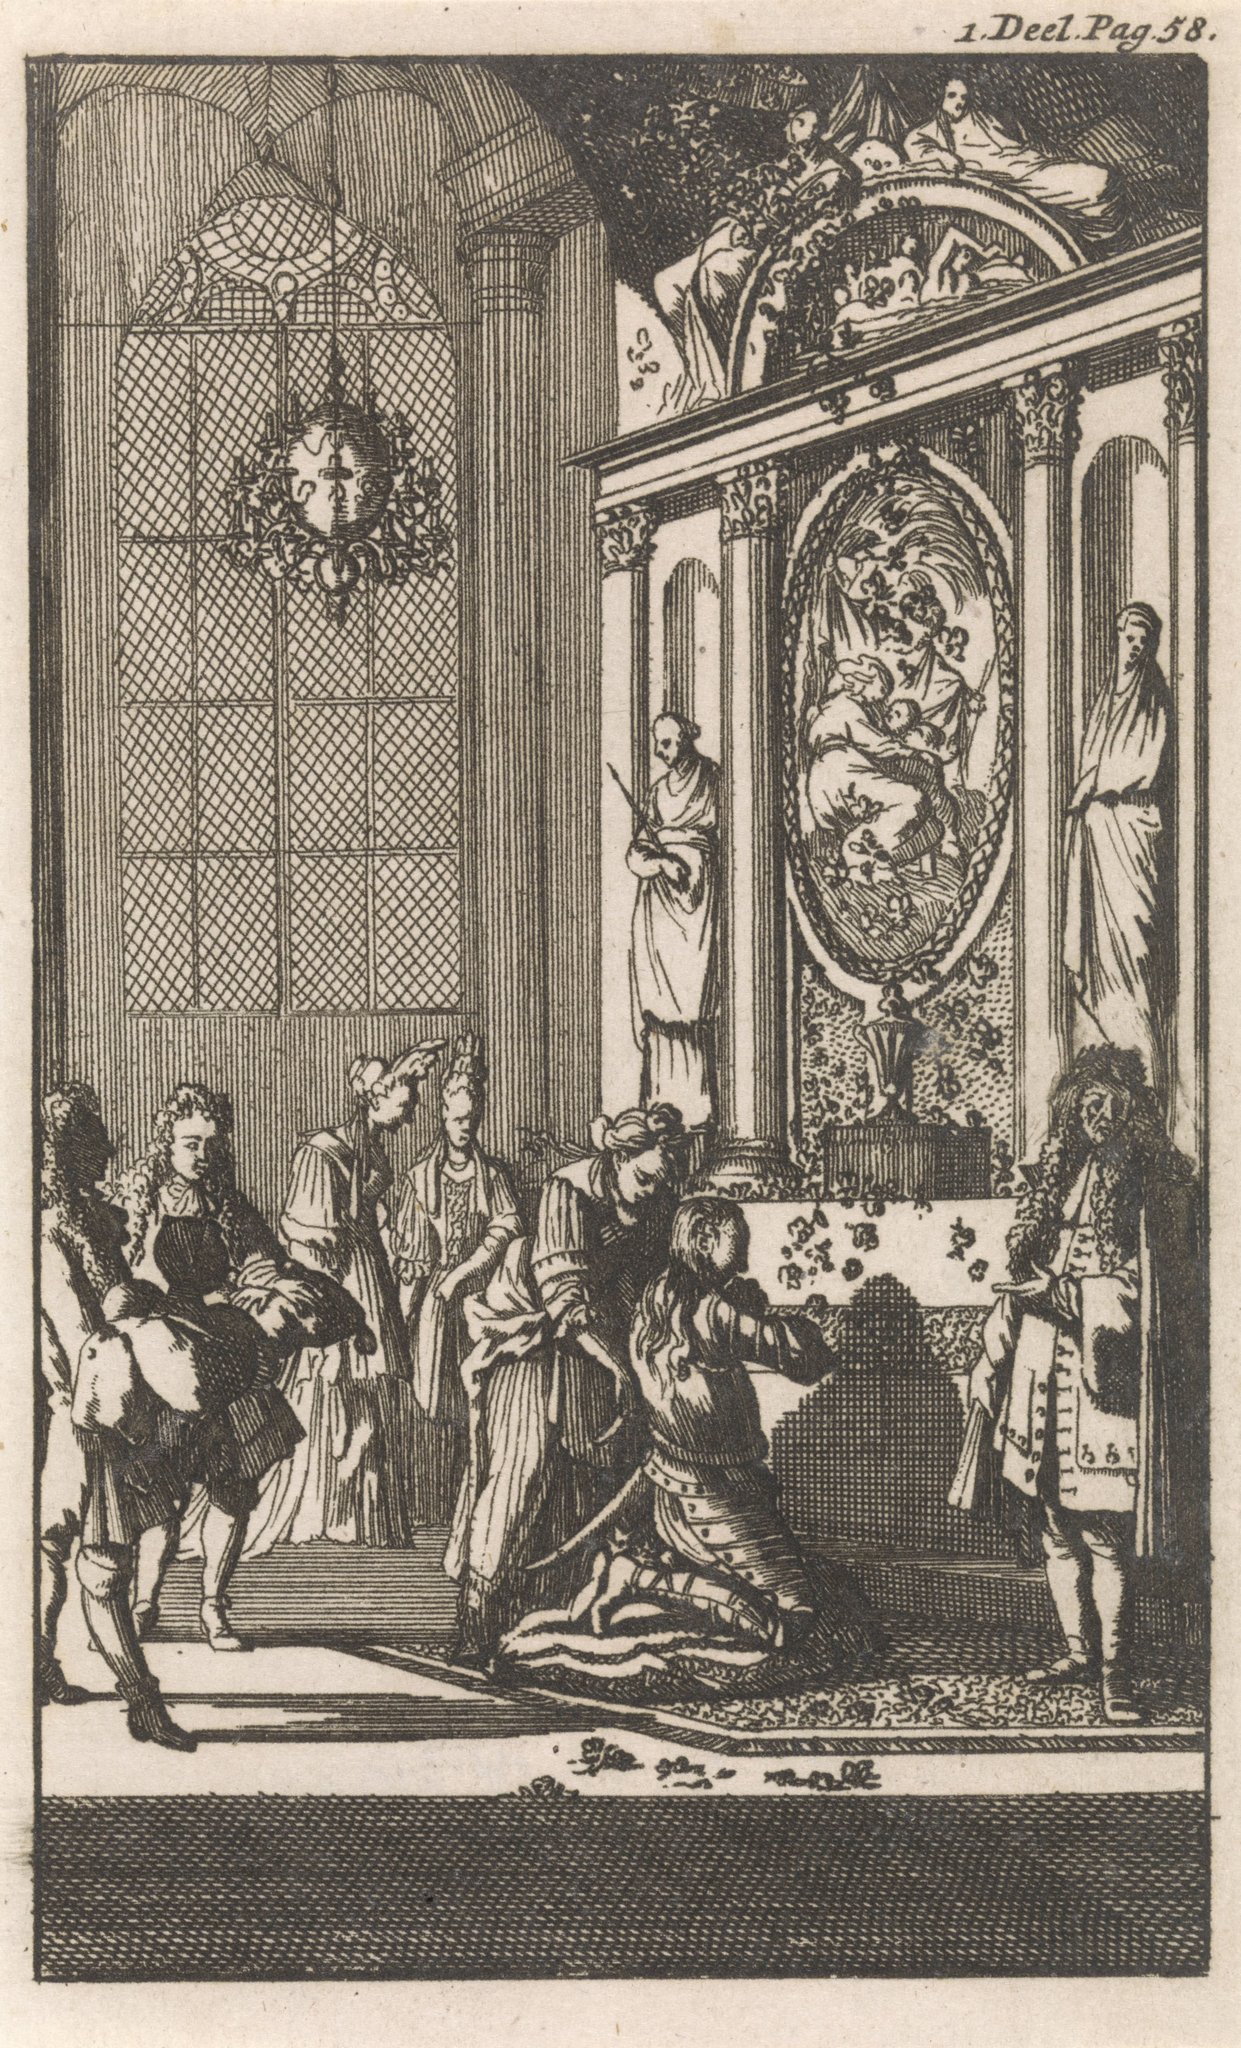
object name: book illustration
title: Don Clarazel tot ridder geslagen in de huiskapel van een edelman nabij Avignon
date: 1697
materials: paper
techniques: etching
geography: amsterdam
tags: knighting ceremonies, knight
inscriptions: collector's mark: Lugt 2228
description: Illustratie uit: Verdier, Gilbert Saulnier du (vert. Heinsius, Nicolaas junior). Don Clarazel de Gontarnos, ofte den buiten-spoorigen dolenden ridder, 2 delen. Amsterdam: Johannes Broersz en Nathanael Holbeex, 1697, dl. 1.